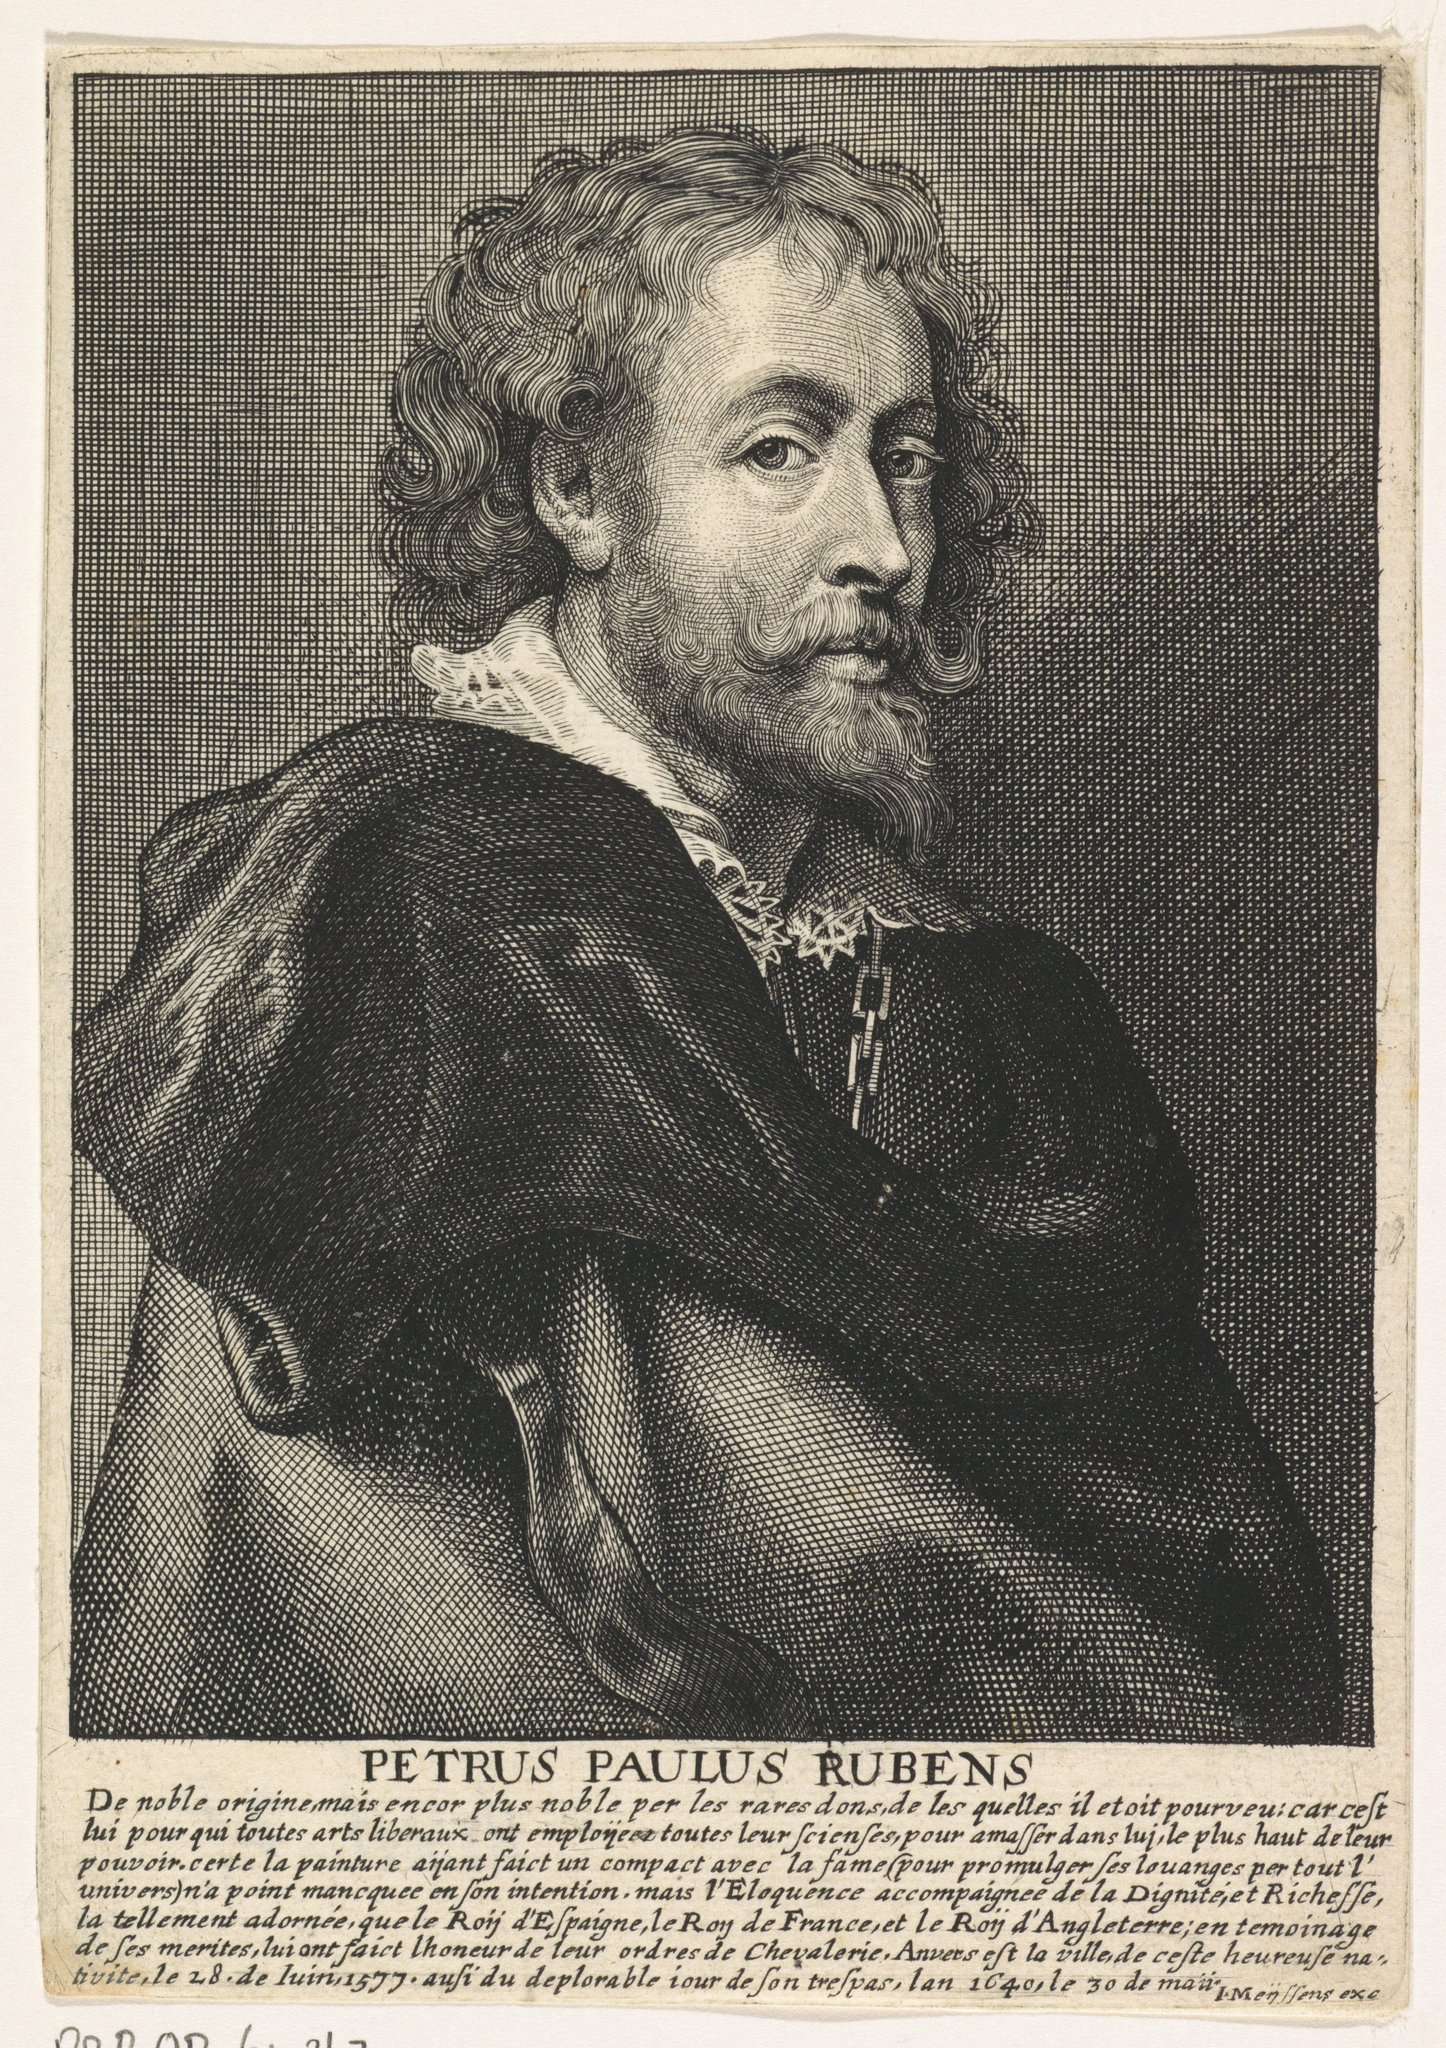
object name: print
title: Portret van de schilder Petrus Paulus Rubens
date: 1649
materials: paper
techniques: engraving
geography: antwerp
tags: antwerp, painter, print maker, draughtsman, peter paul rubens, portrait, self-portrait of painter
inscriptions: collector's mark: Lugt 2228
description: Prent gebruikt in: Image de divers hommes d'esprit sublime, qui par leur art et science devraient vivre éternellement et desquels la louange et renommée faict estonner le monde. Antwerpen: J. Meyssens, 1649.